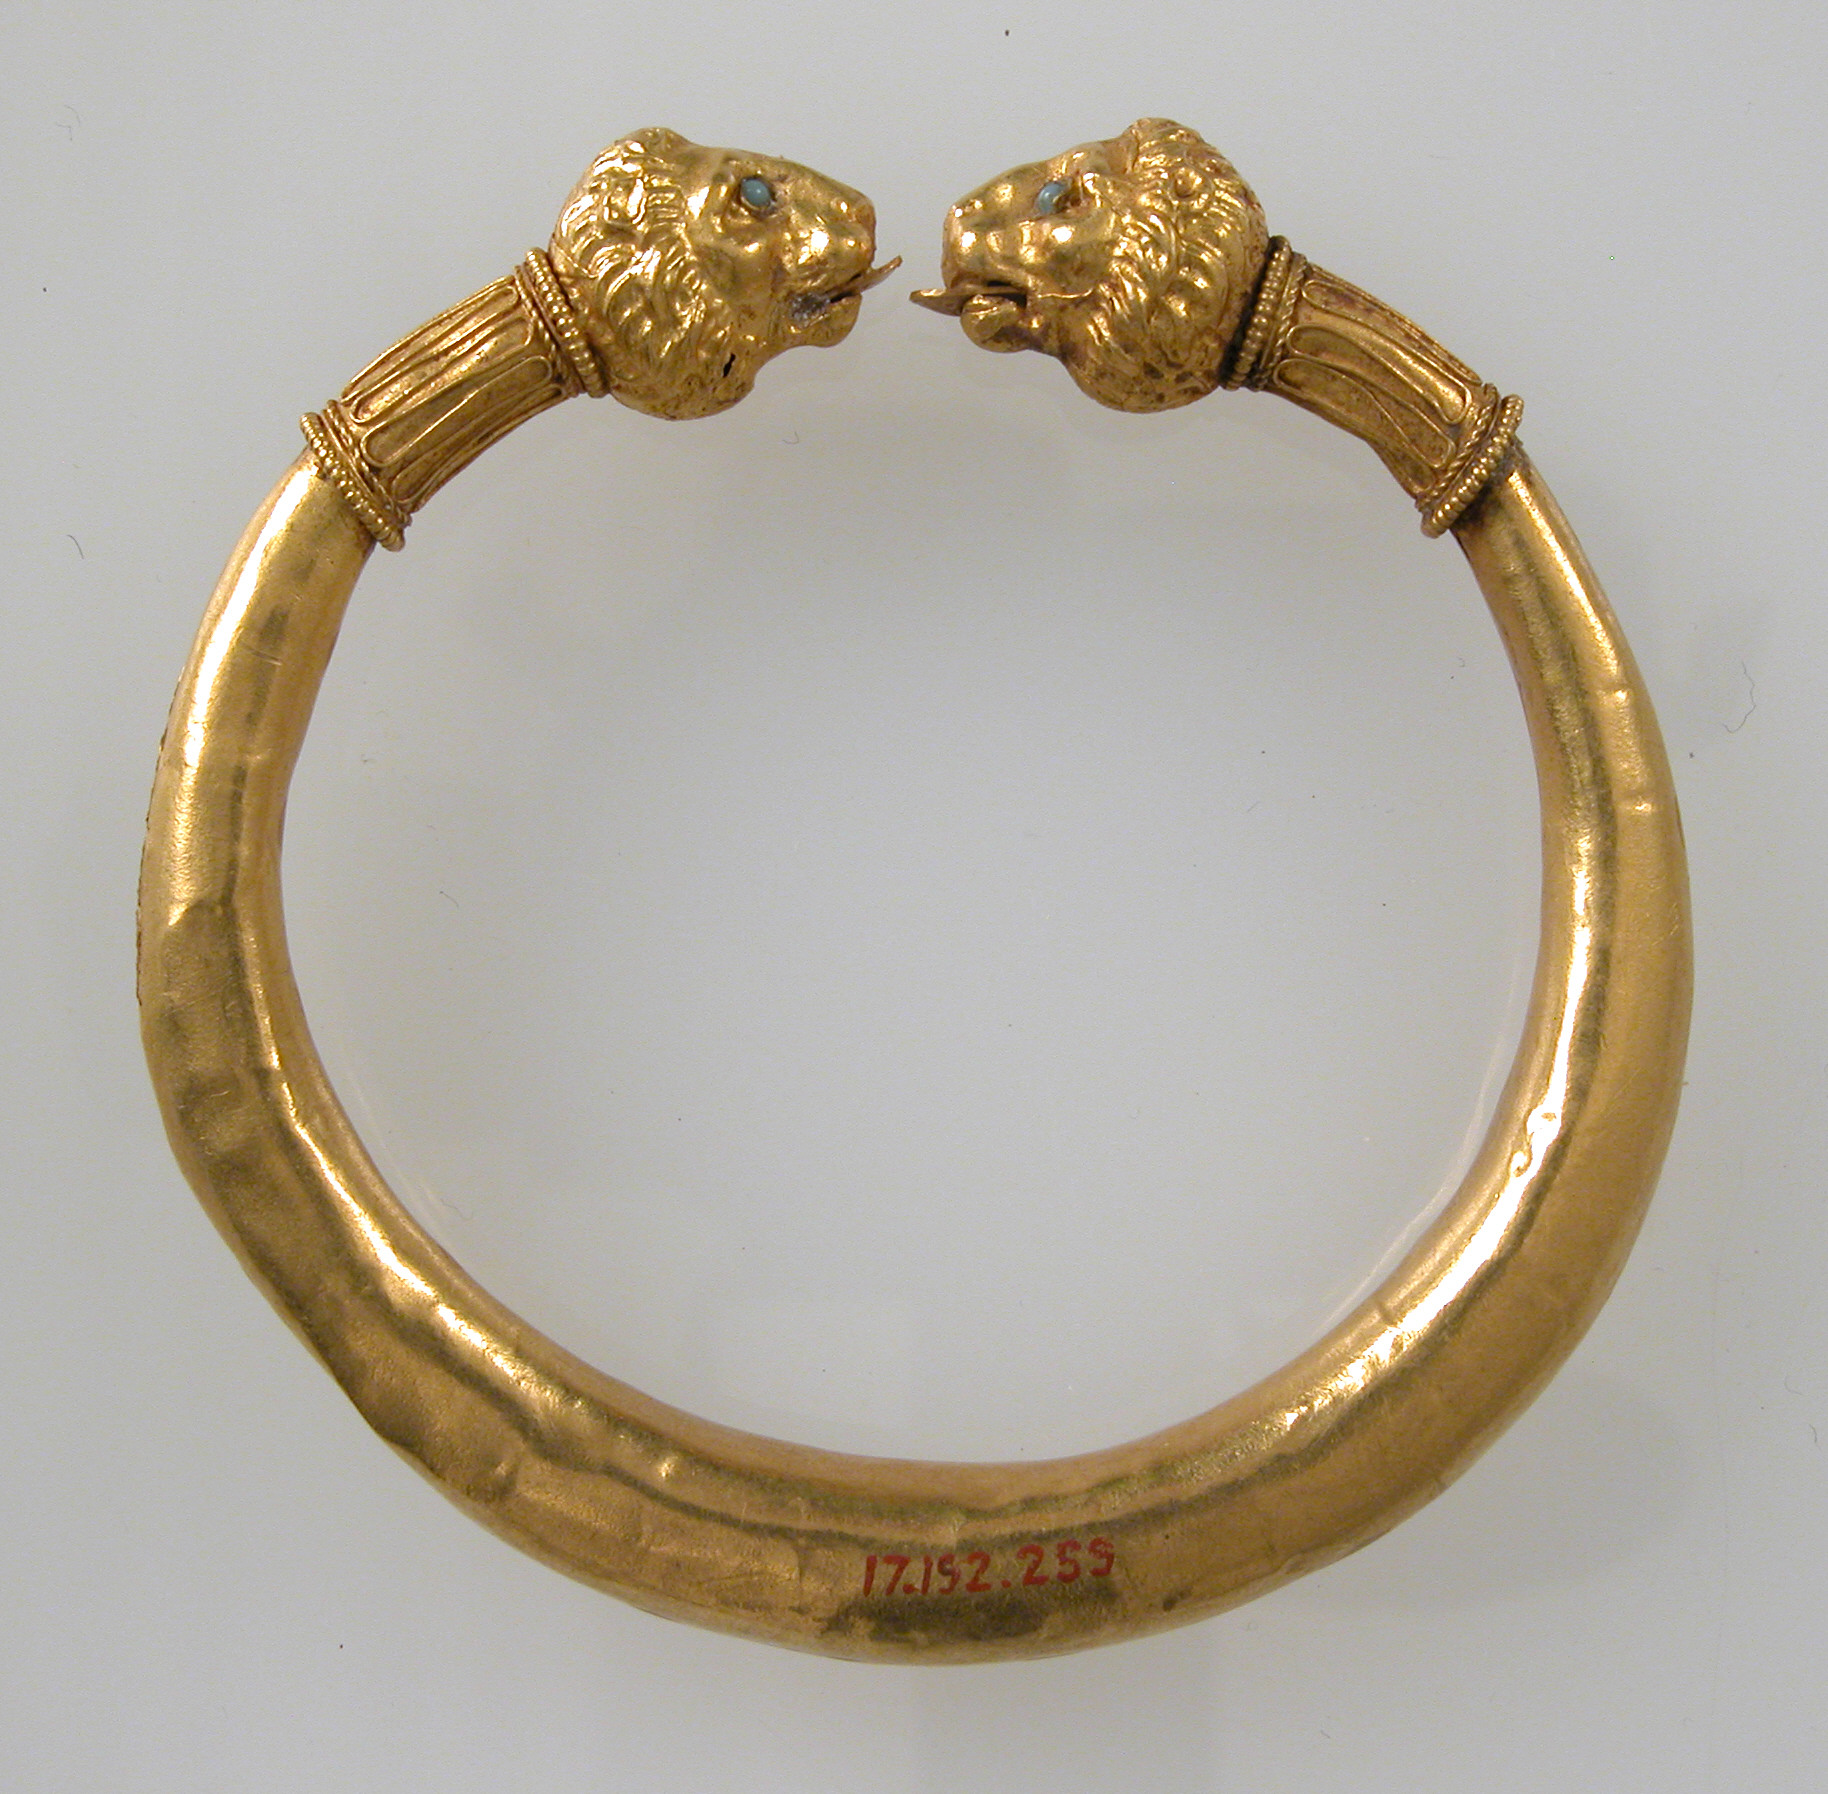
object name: bracelet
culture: pontic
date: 201-300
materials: glass, gold, paste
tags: lions